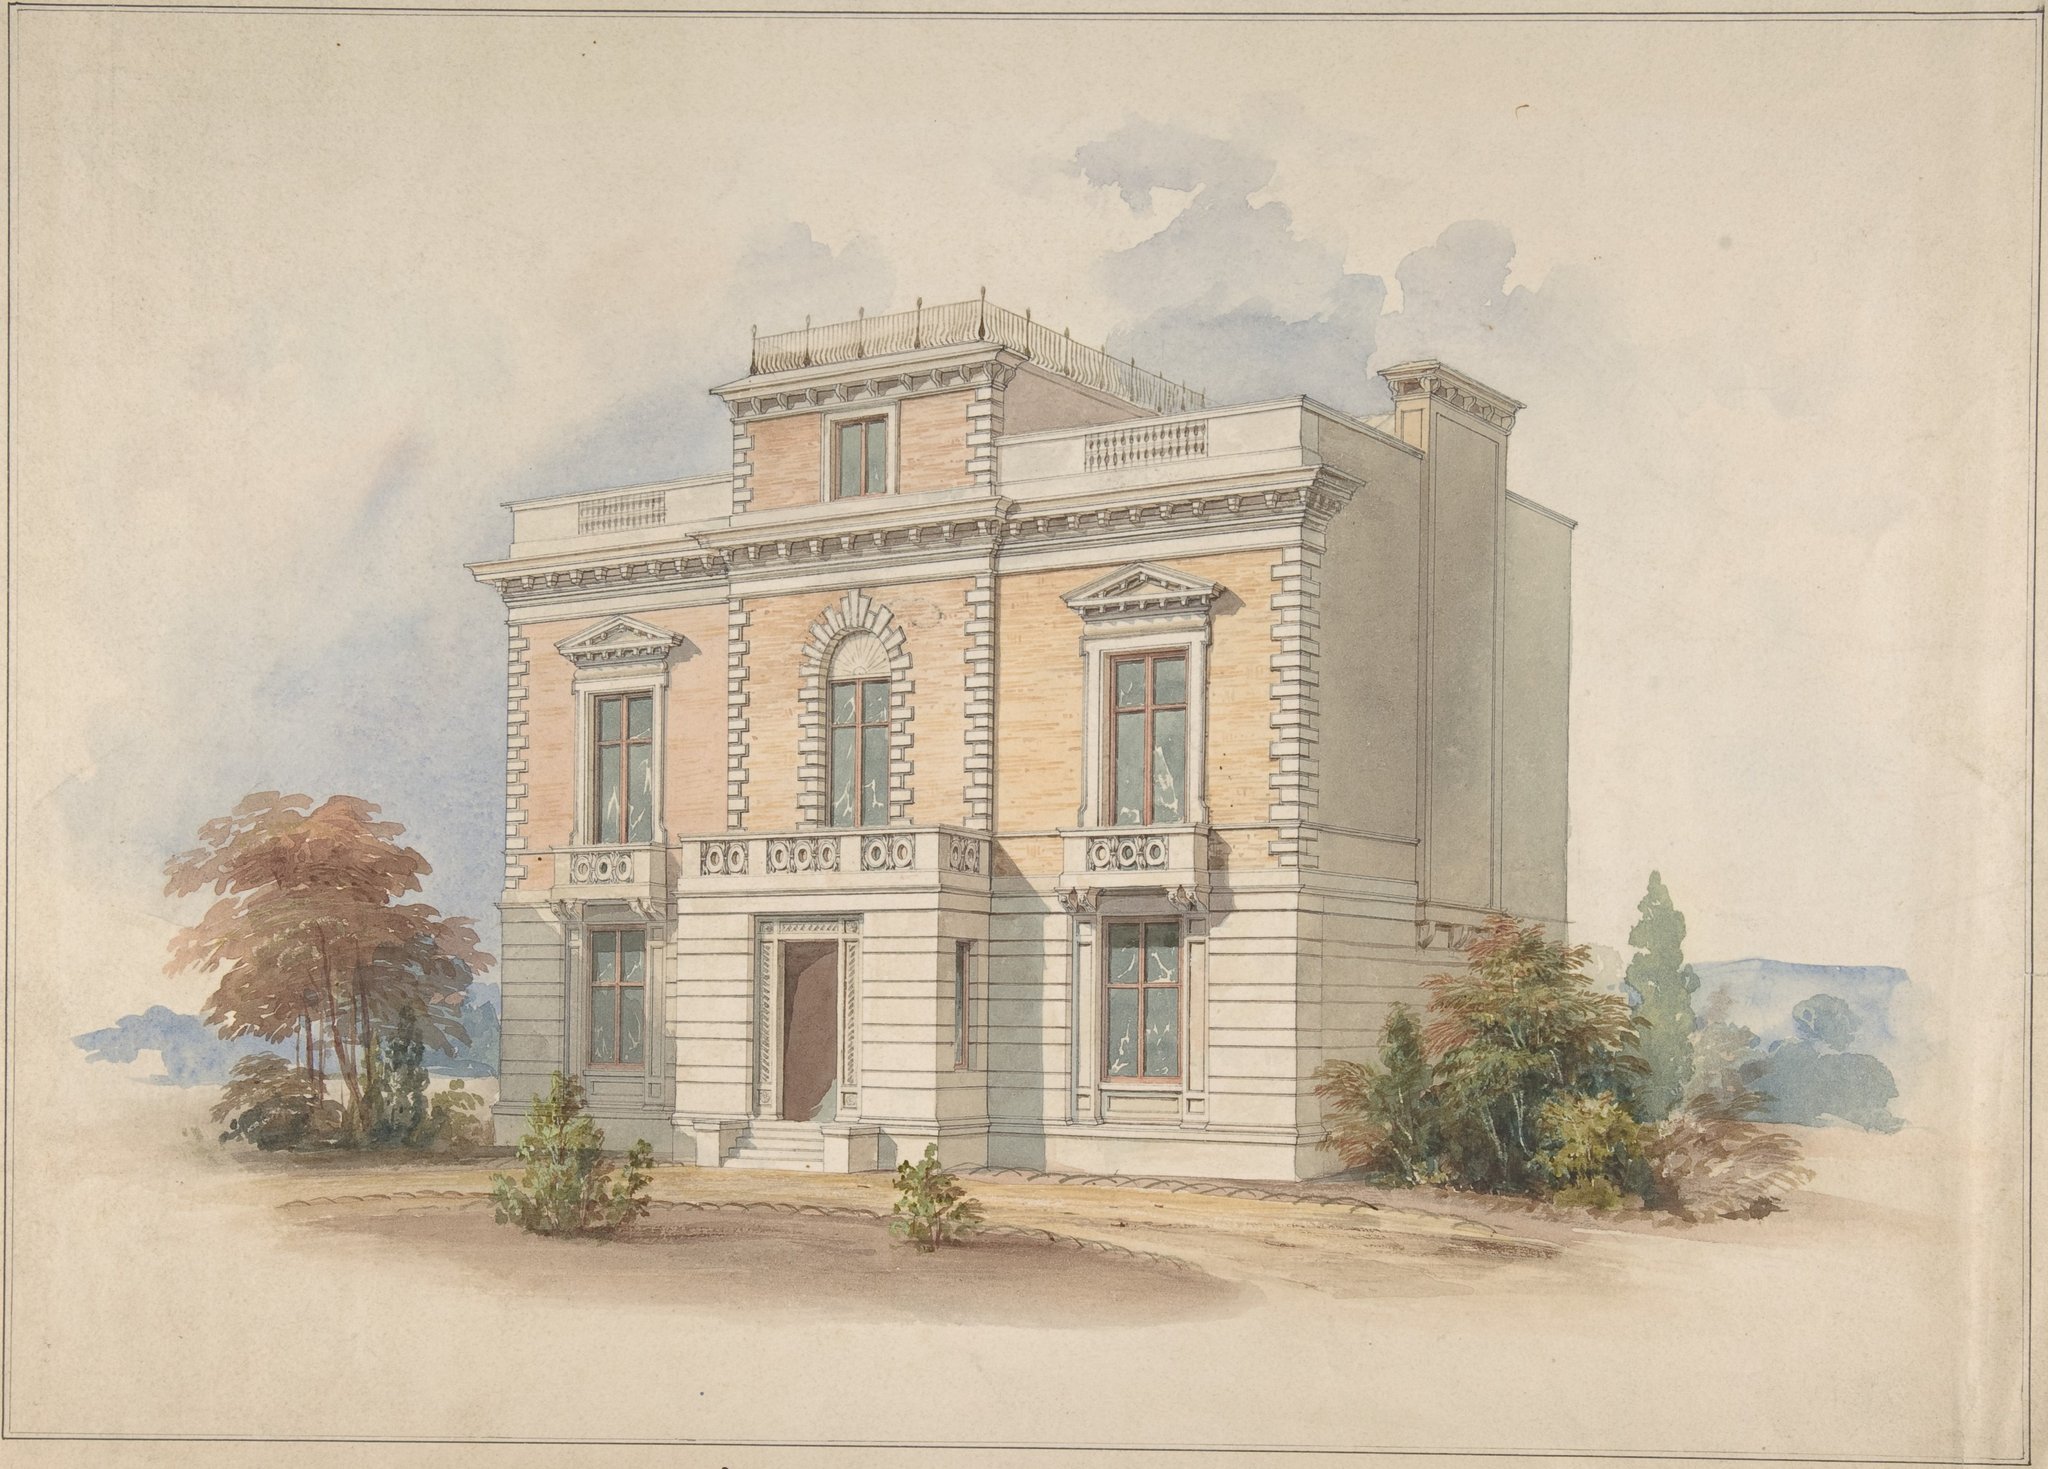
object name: drawing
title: An Italianate Villa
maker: henry edward kendall jr.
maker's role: artist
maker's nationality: british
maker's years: 1805-1885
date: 1820-1885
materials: ink, watercolor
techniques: pen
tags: houses